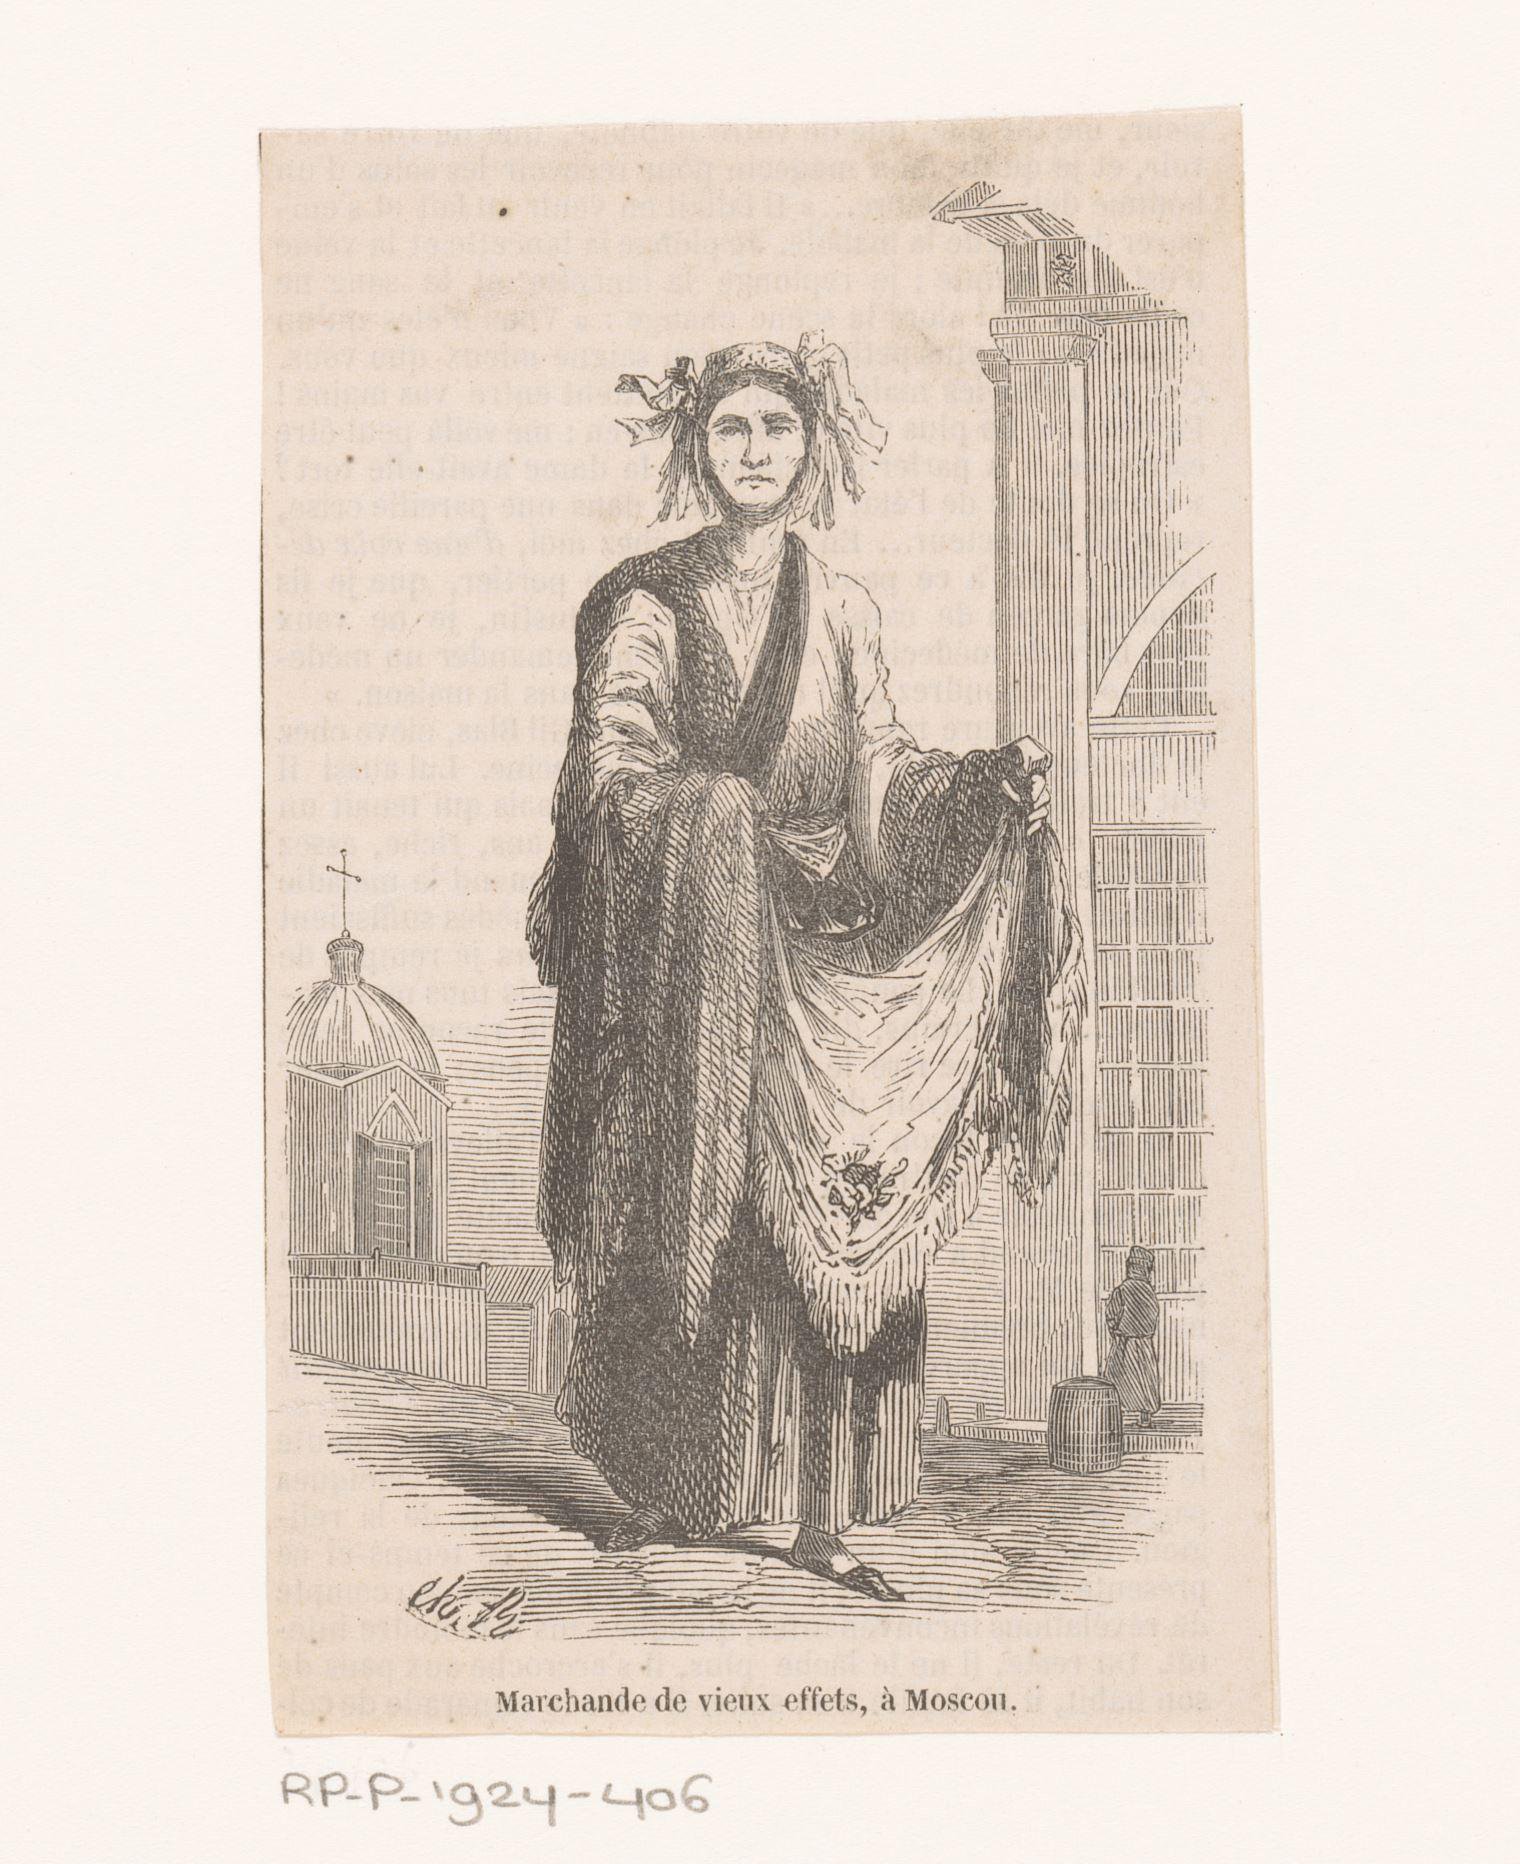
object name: print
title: Beroepen in Rusland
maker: ch. reboul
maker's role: print maker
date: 1826-1899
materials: paper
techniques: letterpress printing, engraving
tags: merchant, salesman - bb - women engaged in trade and commerce, europeans (with name)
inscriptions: collector's mark: Lugt 2233